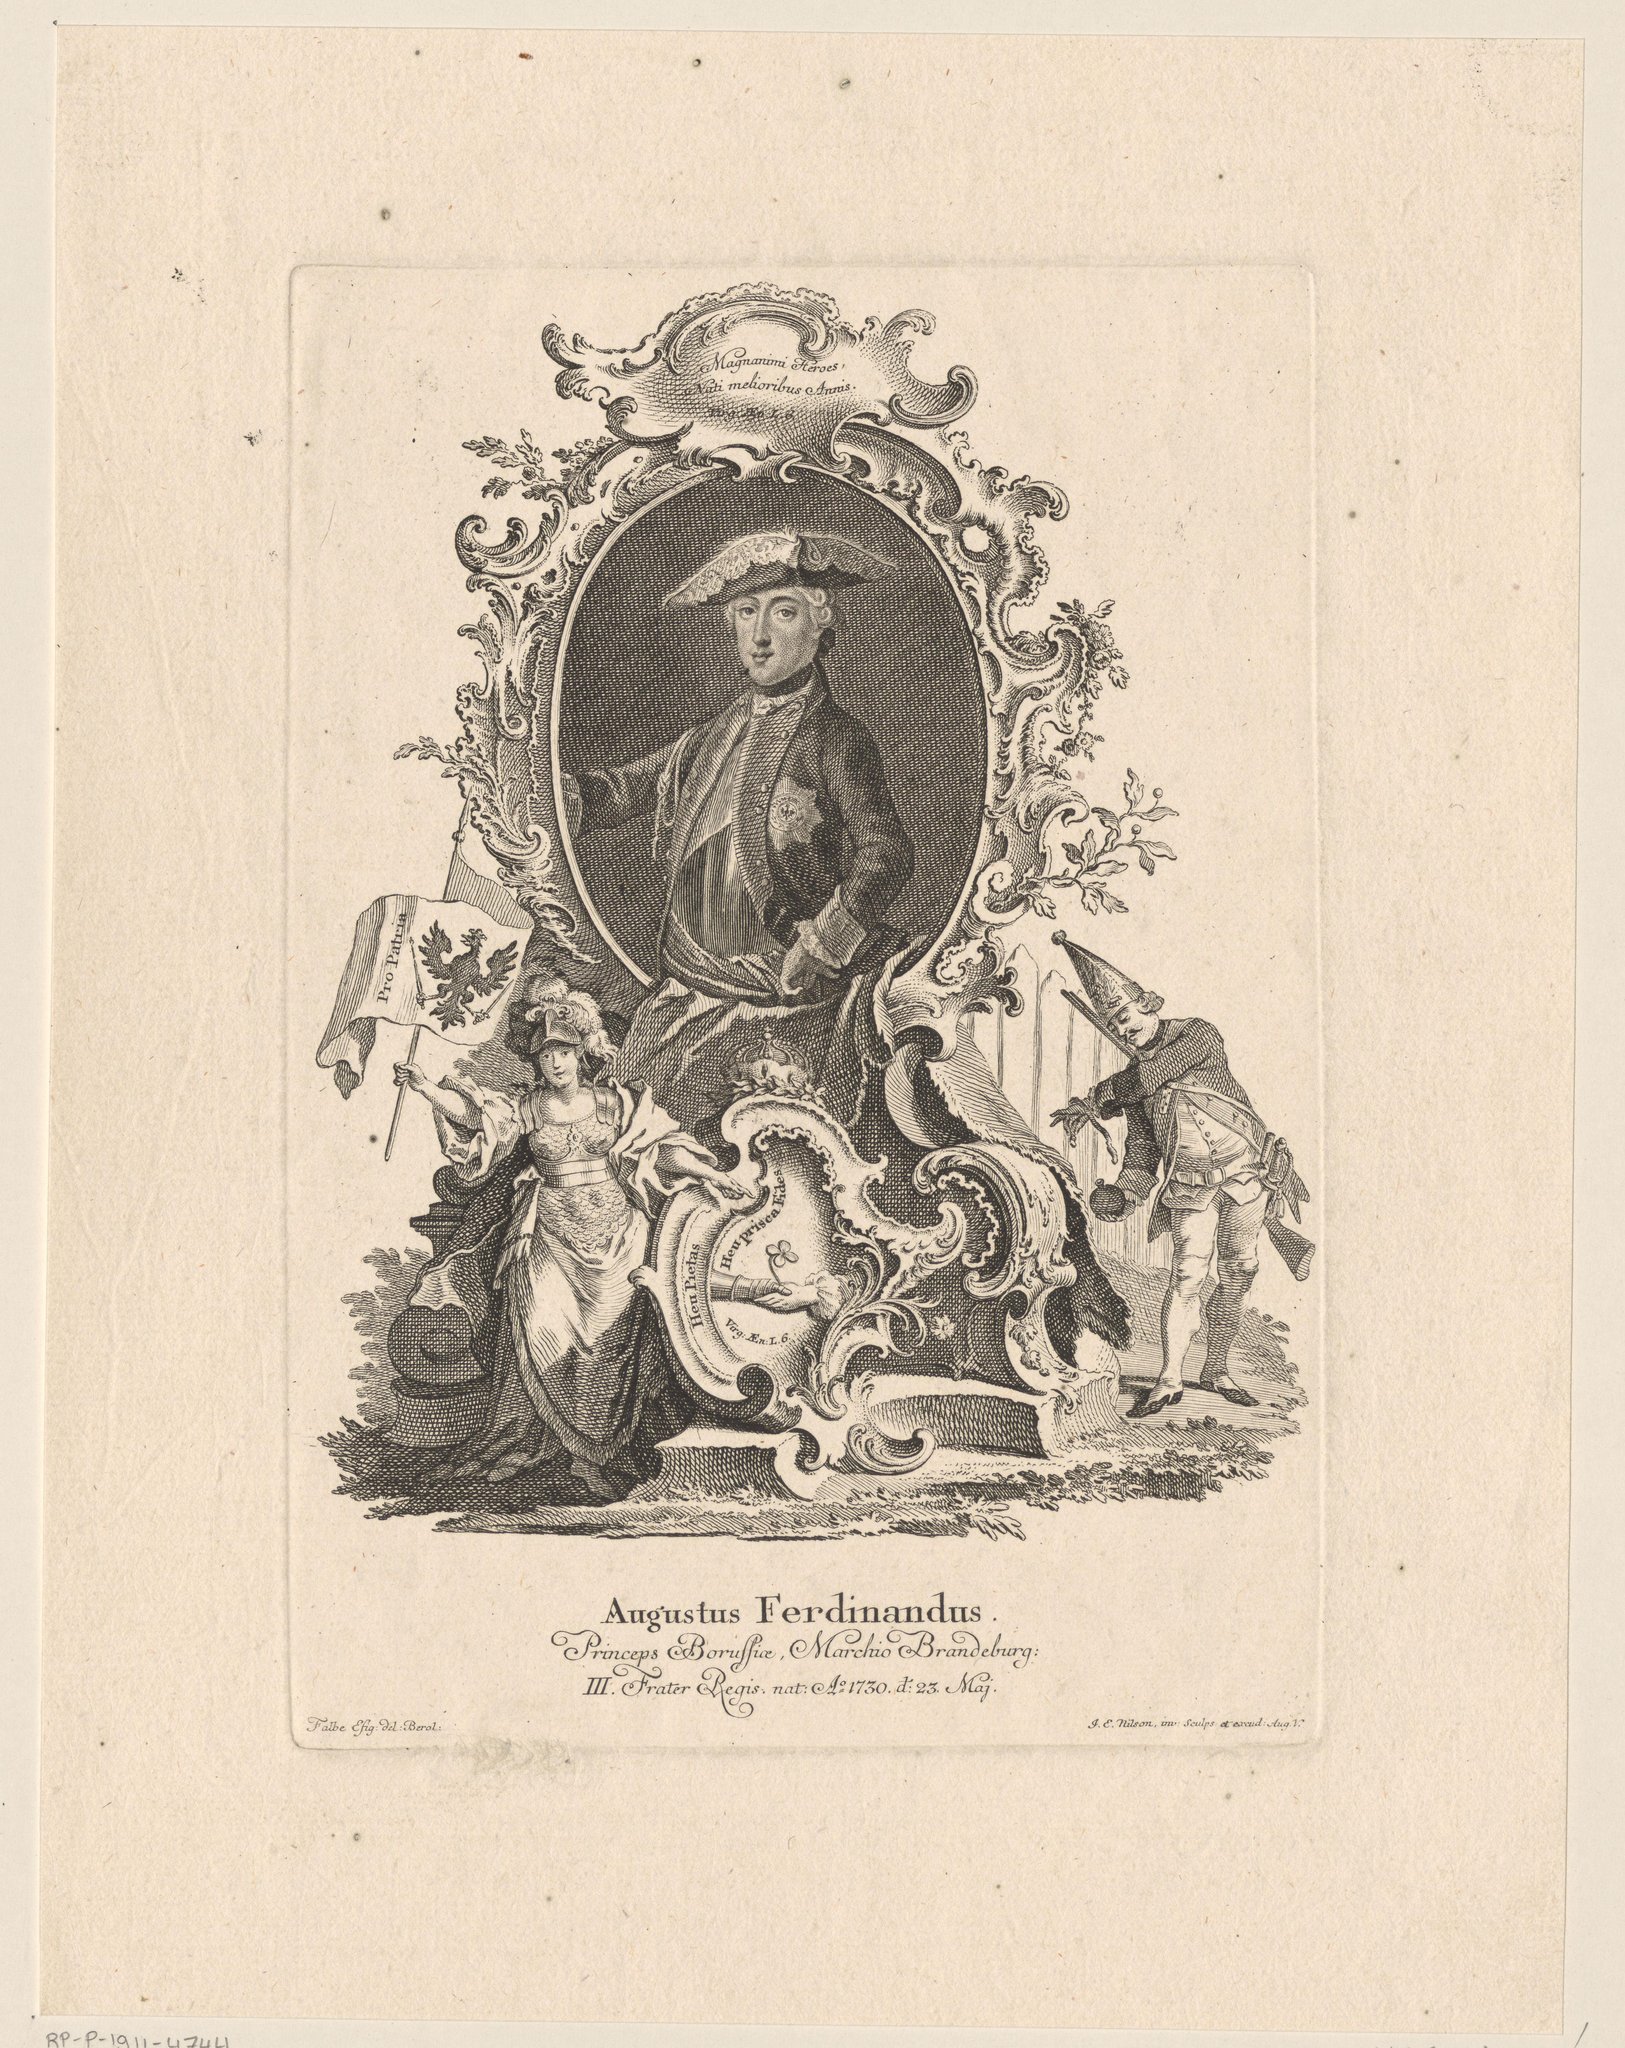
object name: print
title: Portret van August Ferdinand, prins van Pruisen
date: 1762-1788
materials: paper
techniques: engraving, etching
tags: berlin, clover - fantastic plants, fabulous vegetation, historical persons, the soldier; the soldier's life, armorial bearing, heraldry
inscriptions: collector's mark: Lugt 2228